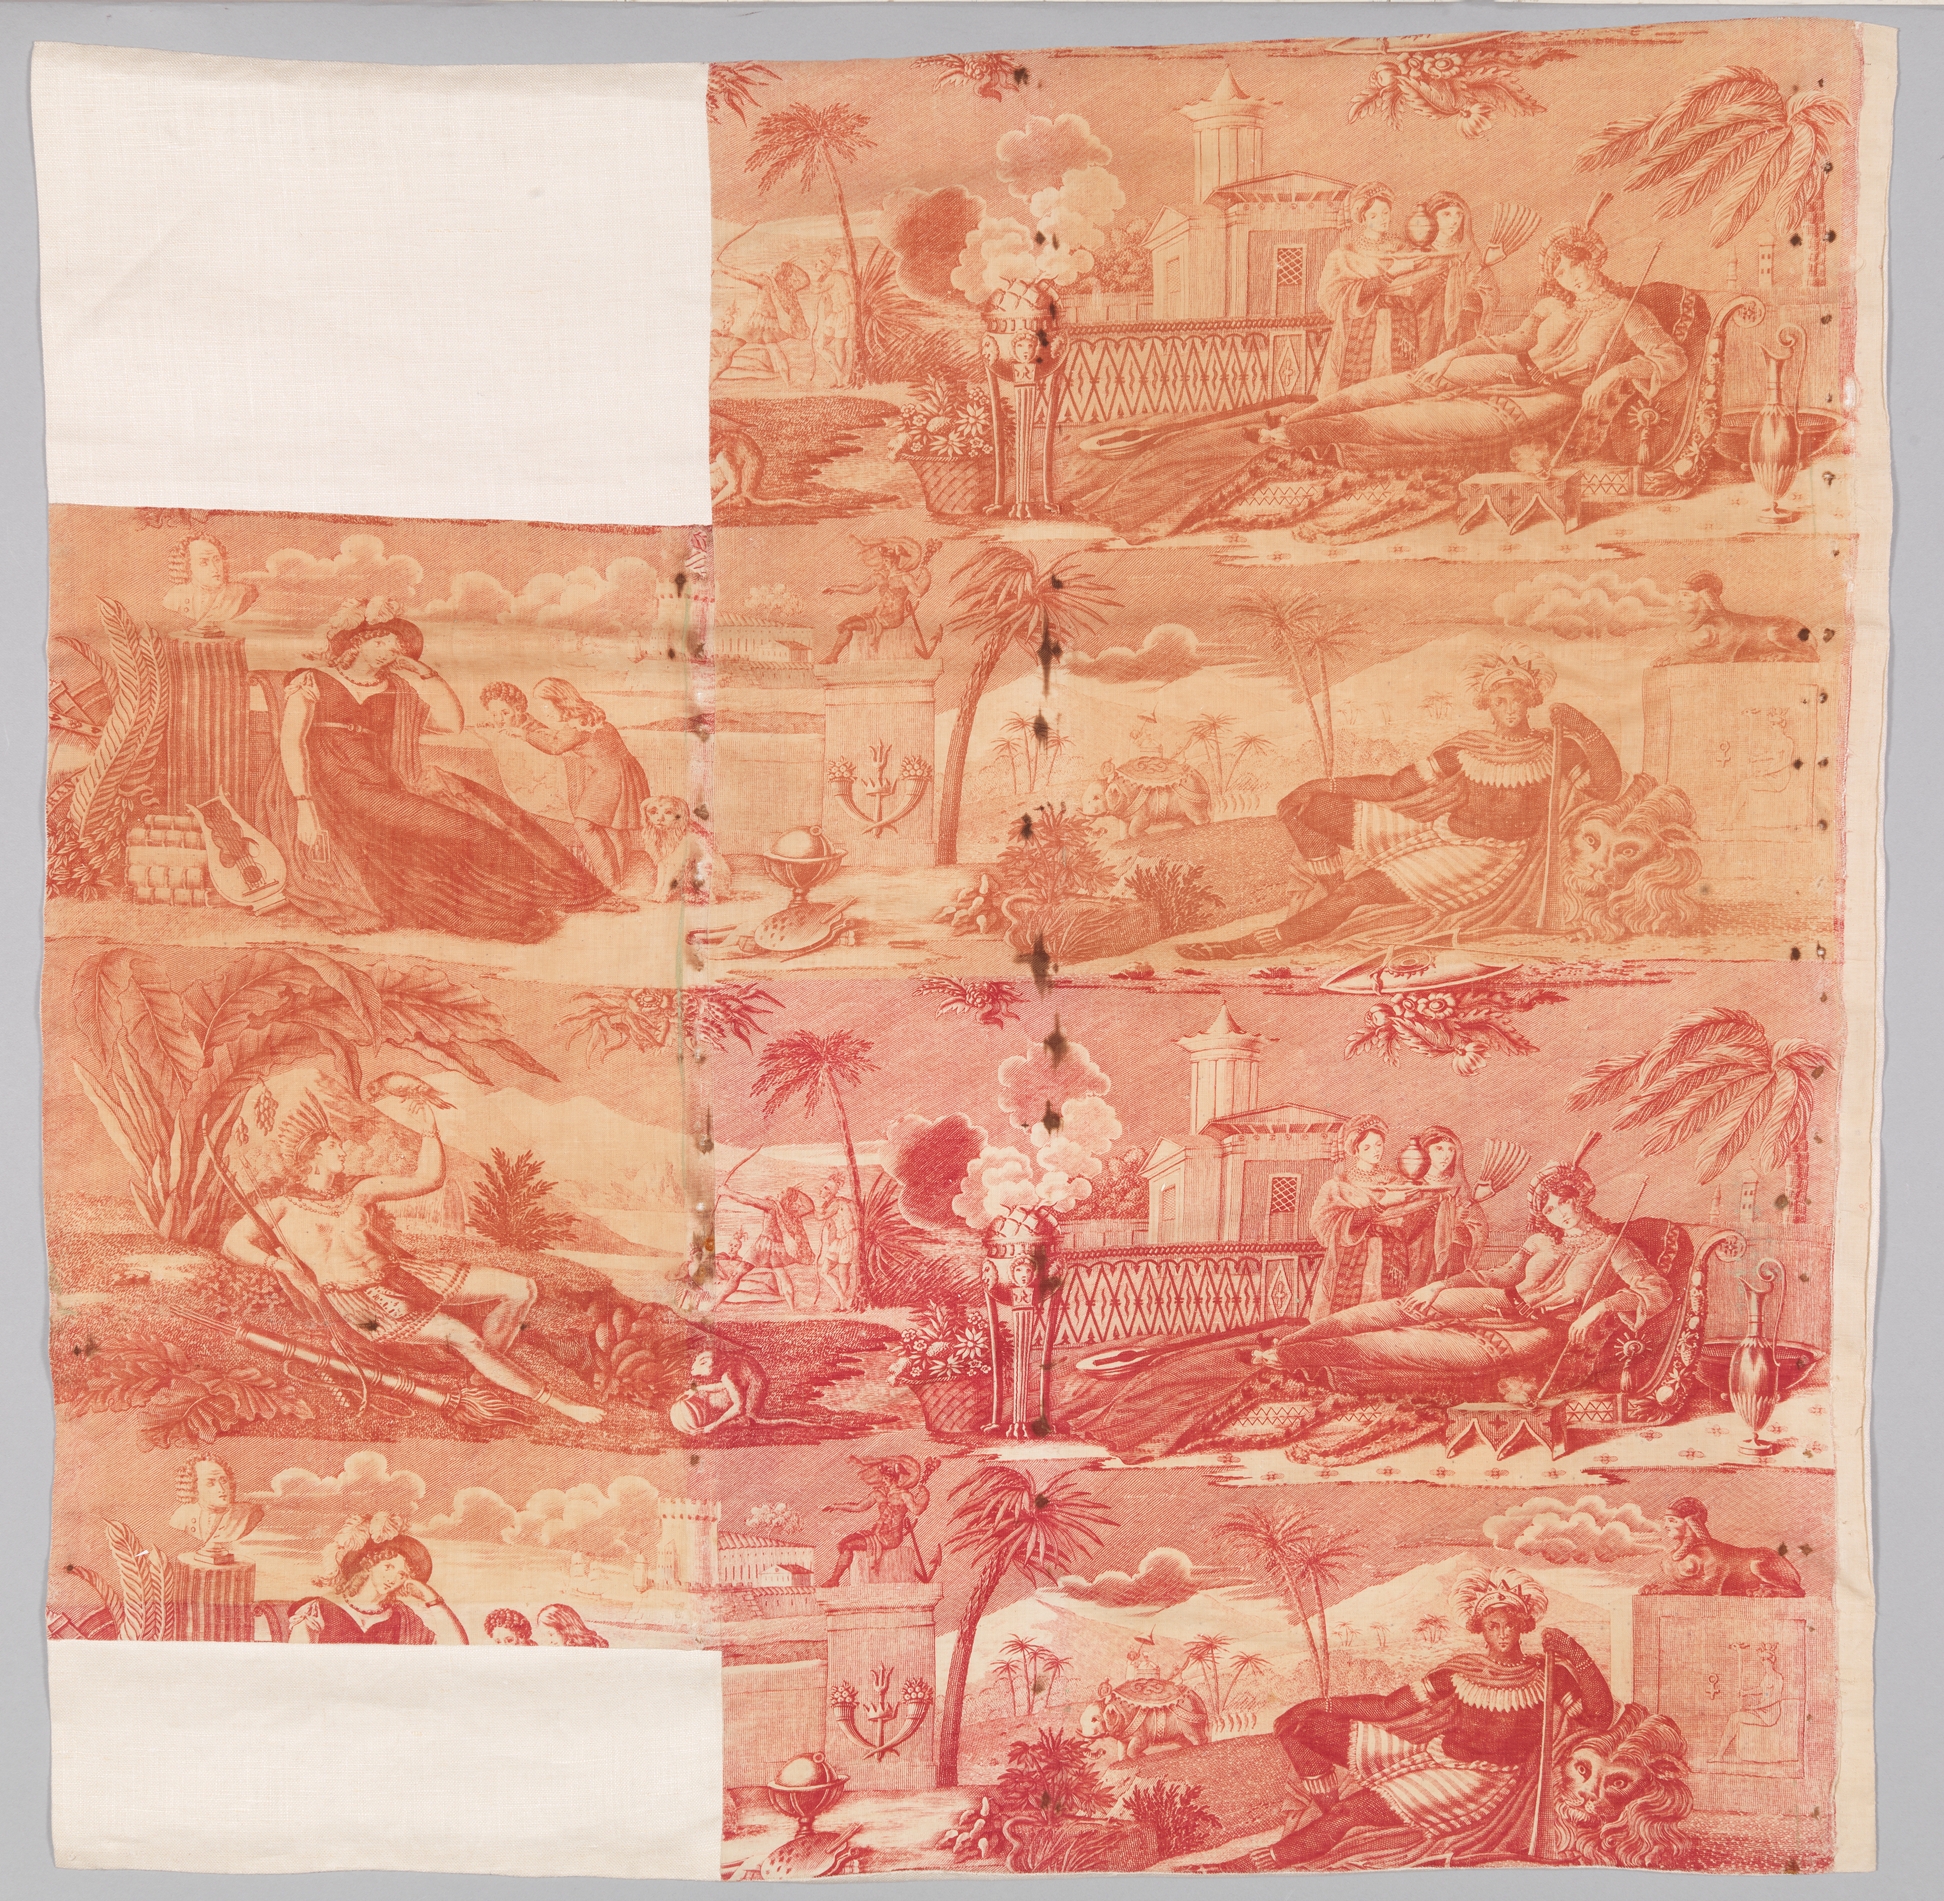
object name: panel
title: Two panels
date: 1820-1830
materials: cotton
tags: animals,men,women,sphinx,elephants